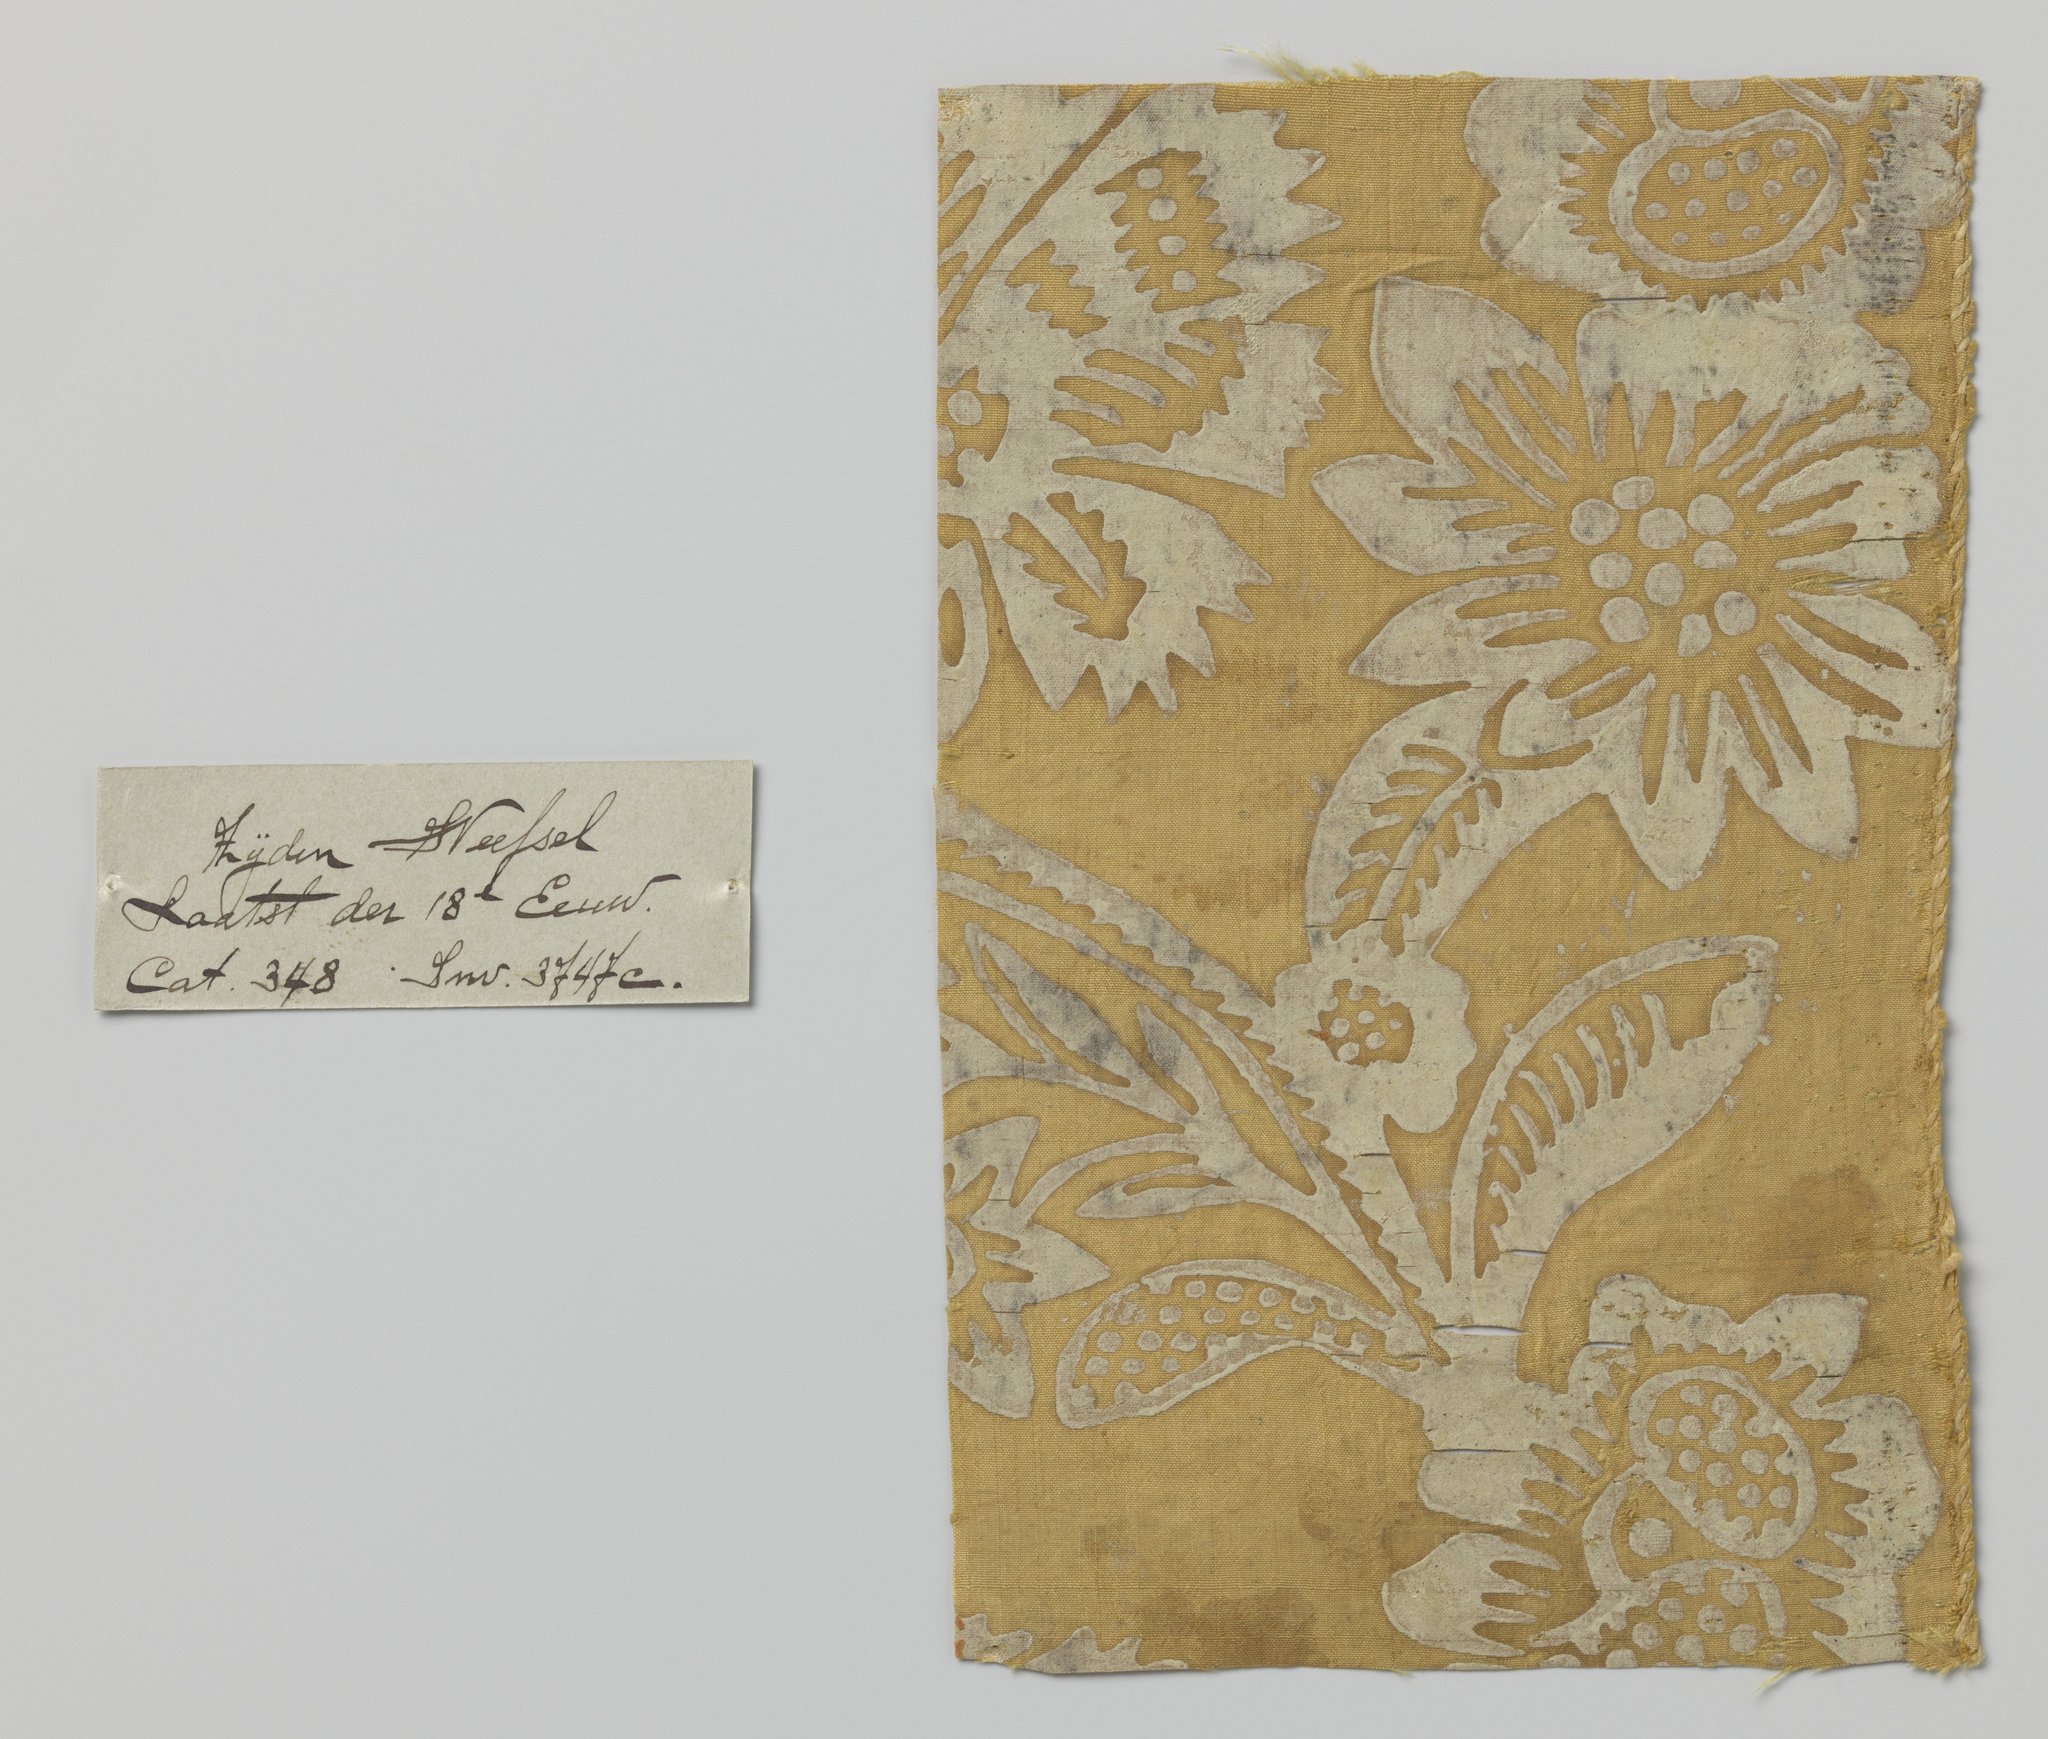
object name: woven material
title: Fragment van geel zijden weefsel met witte bloemen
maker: Anonymous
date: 1775-1799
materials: silk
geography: germany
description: Fragment van geel zijden weefsel met witte bloemen.